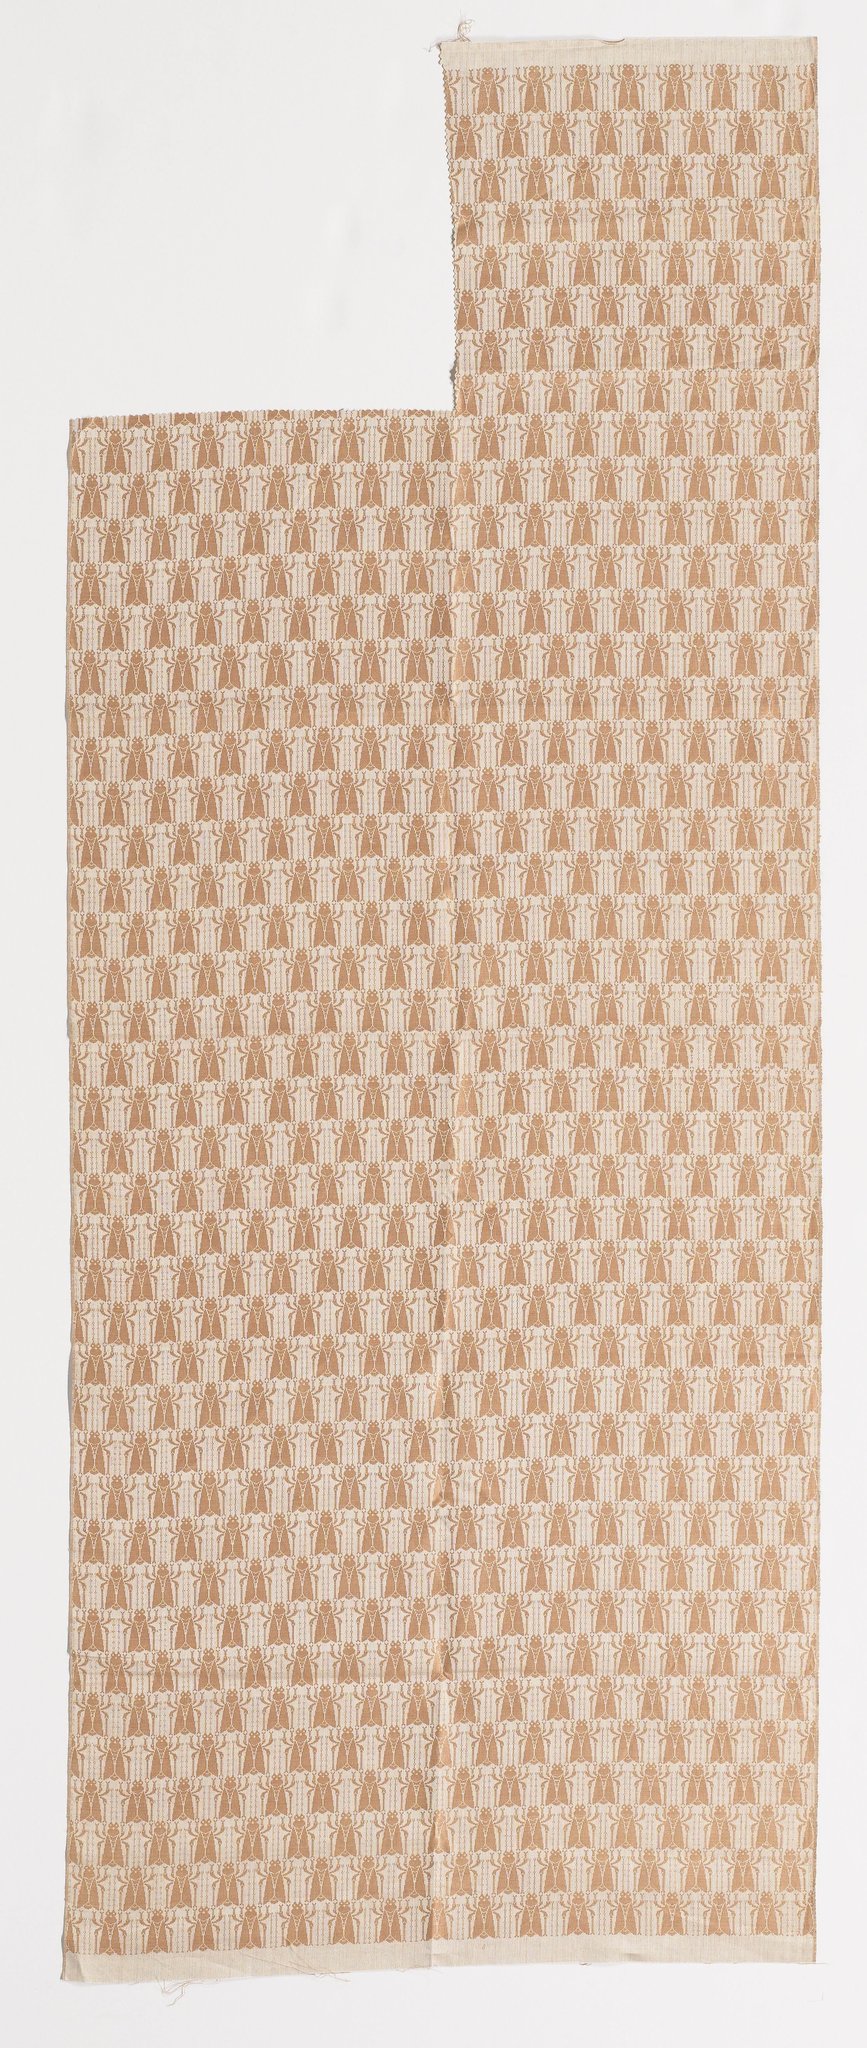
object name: upholstered wall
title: Wandbespanning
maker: chris lebeau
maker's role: draughtsman, print maker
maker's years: 1878-1945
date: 1911-1915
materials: linen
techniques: damask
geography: eindhoven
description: Lichtbruine damasten wandbespanning met een dessin van bijen.